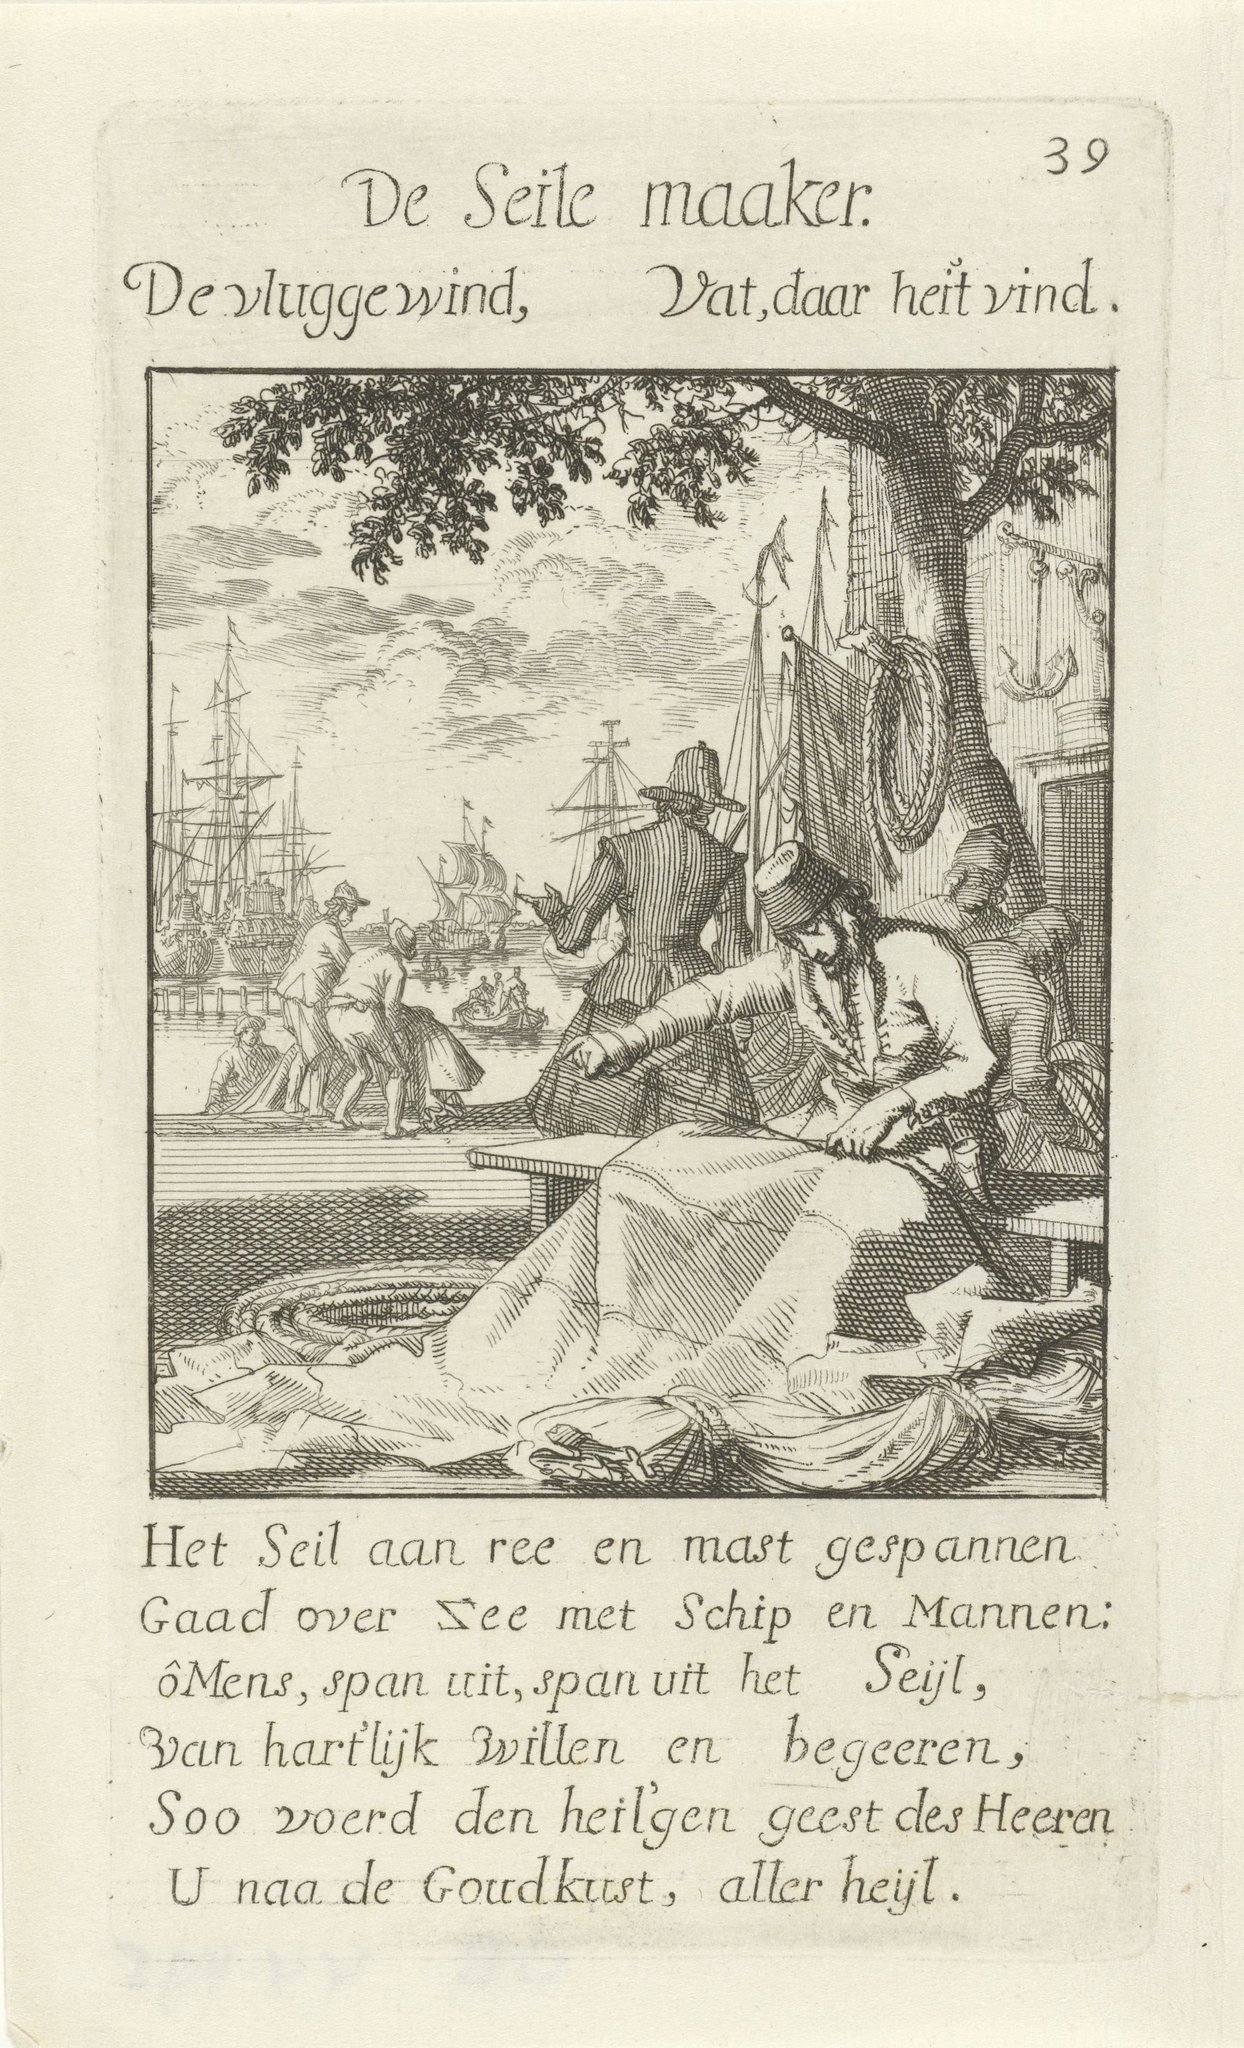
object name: print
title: Het Menselyk Bedryf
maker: jan luyken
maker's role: draughtsman, print maker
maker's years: 1649-1712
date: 1694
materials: paper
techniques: etching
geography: amsterdam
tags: sail, handicrafts, craftsman at work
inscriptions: collector's mark: Lugt 2228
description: Maakt deel uit van de 100-delige serie beroepsprenten van Jan en Caspar Luyken, getiteld: Het menselyk bedryf. S.l.s.n., 1694 (eerste druk).